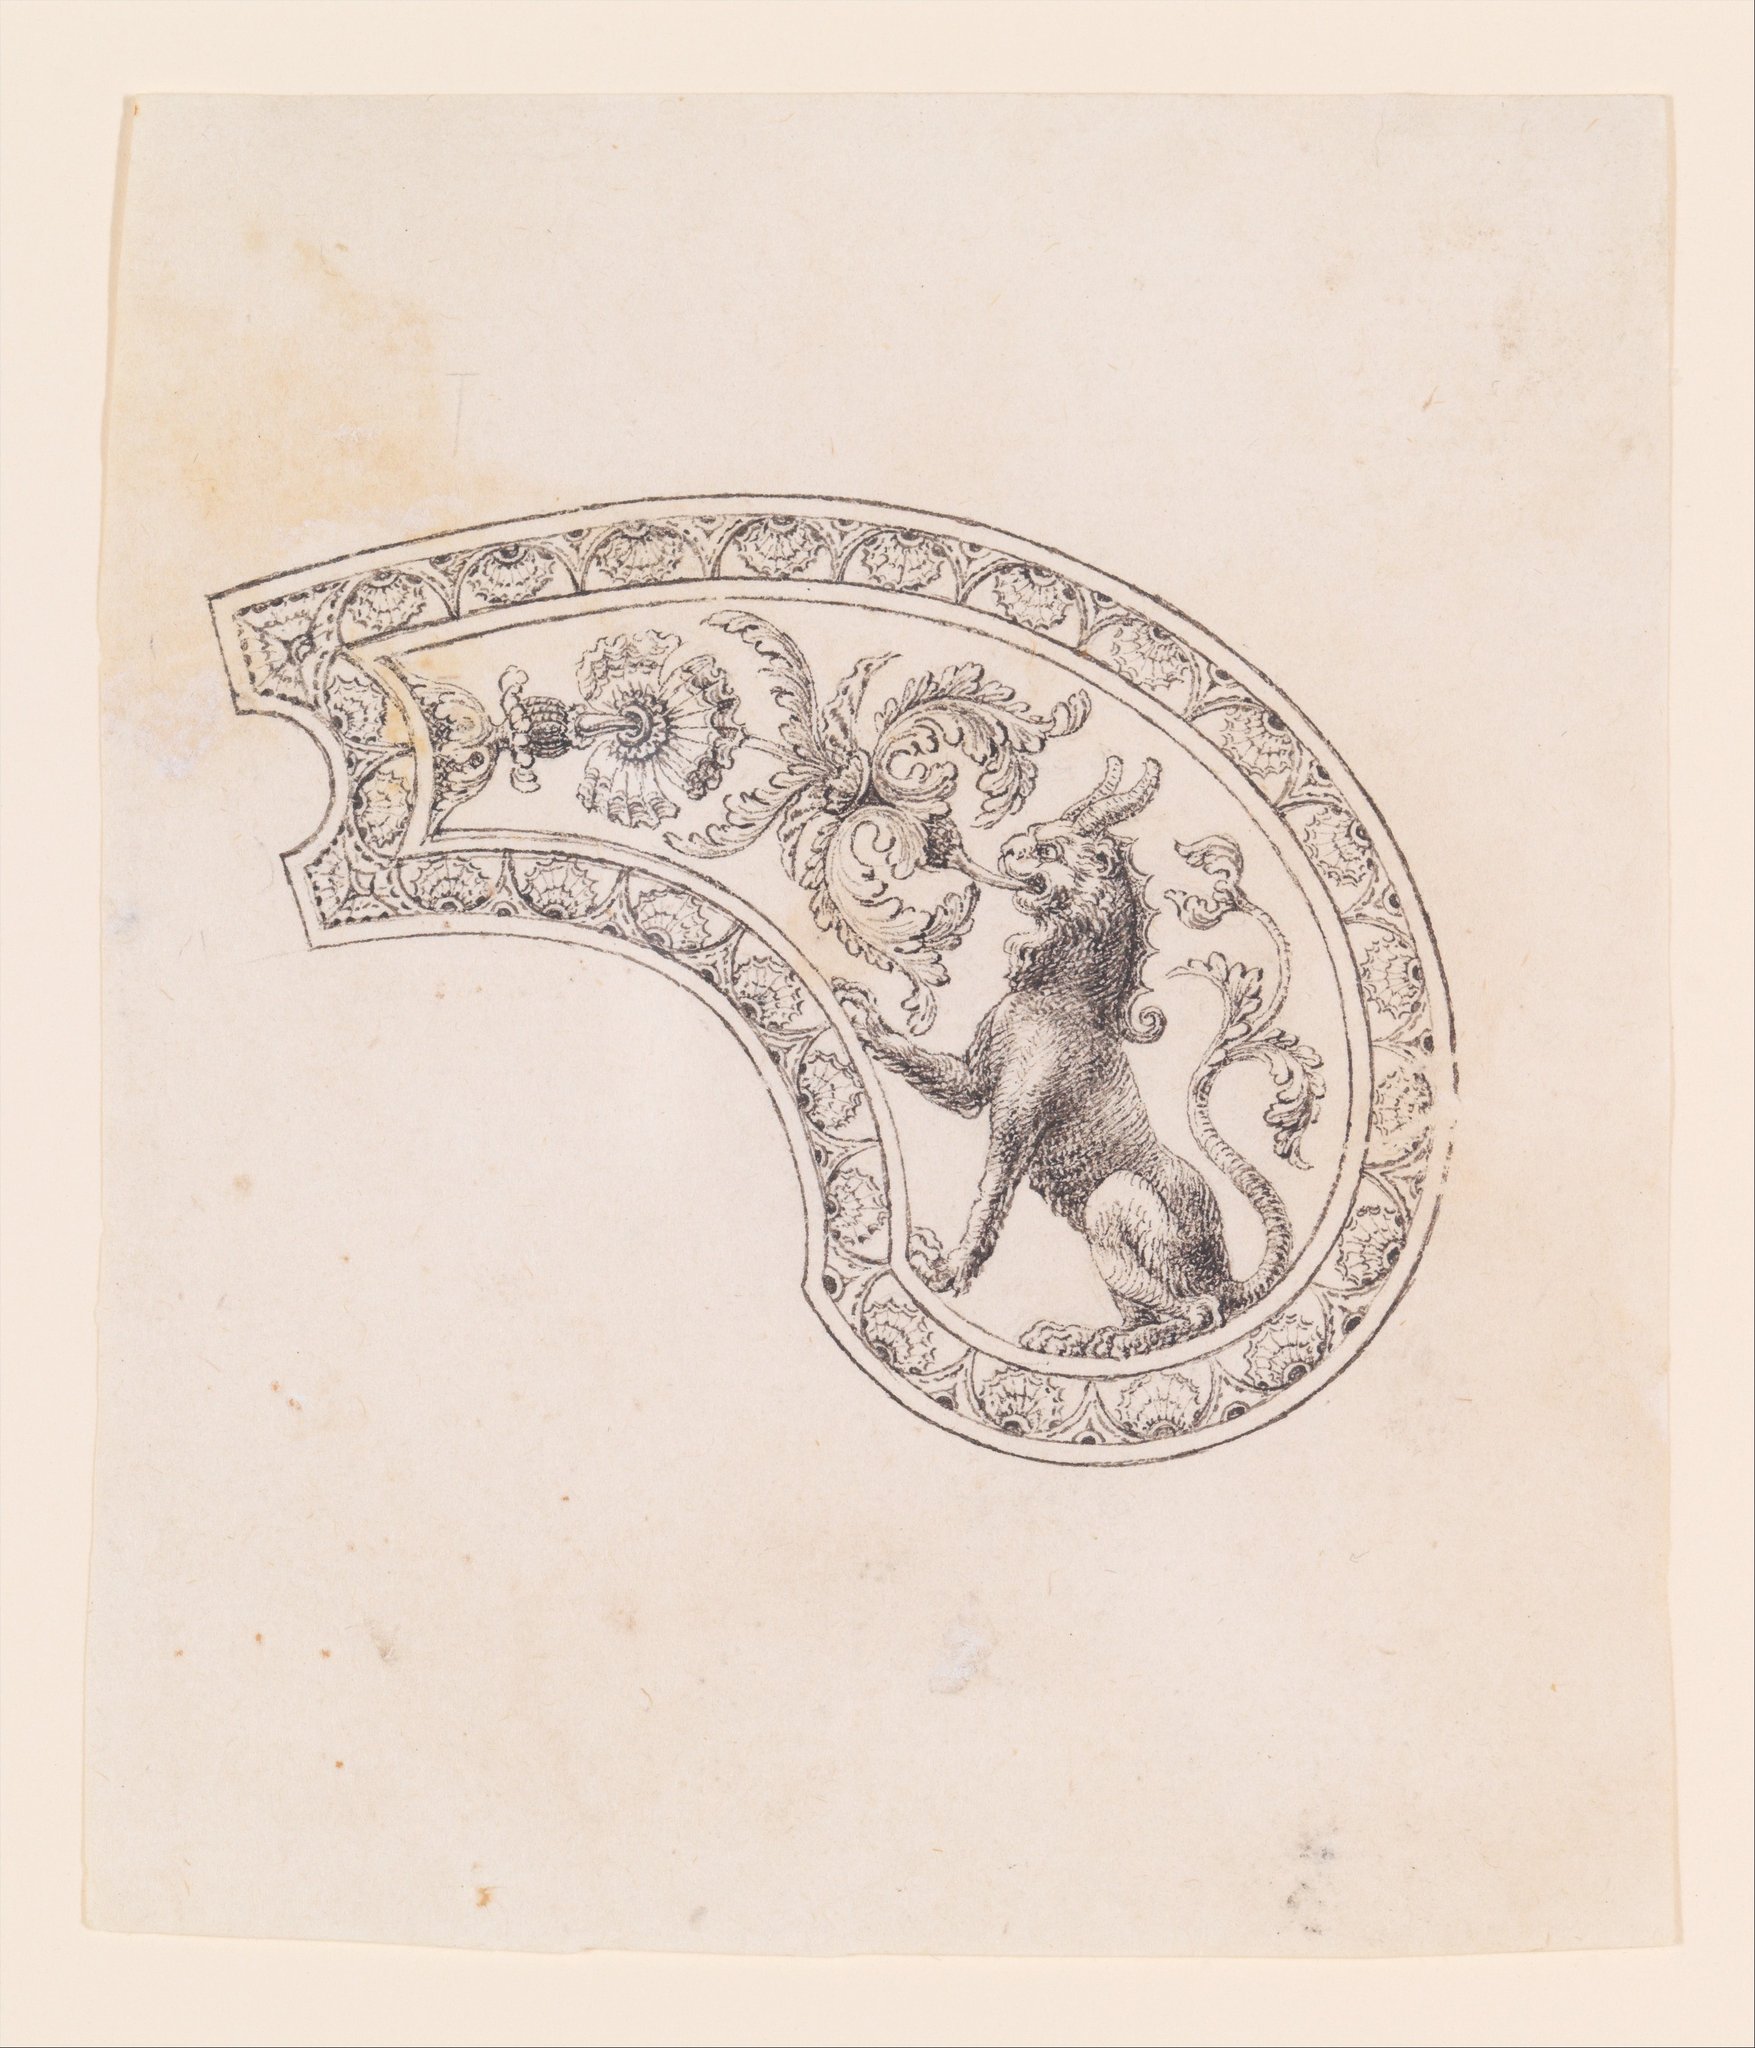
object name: drawing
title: Design for the Decoration of the Grip of a Pocket Pistol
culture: french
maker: nicolas noël boutet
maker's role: designer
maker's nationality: french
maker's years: 1761-1833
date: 1797-1805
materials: ink, paper, pencil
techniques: wash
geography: france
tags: ornament,griffins